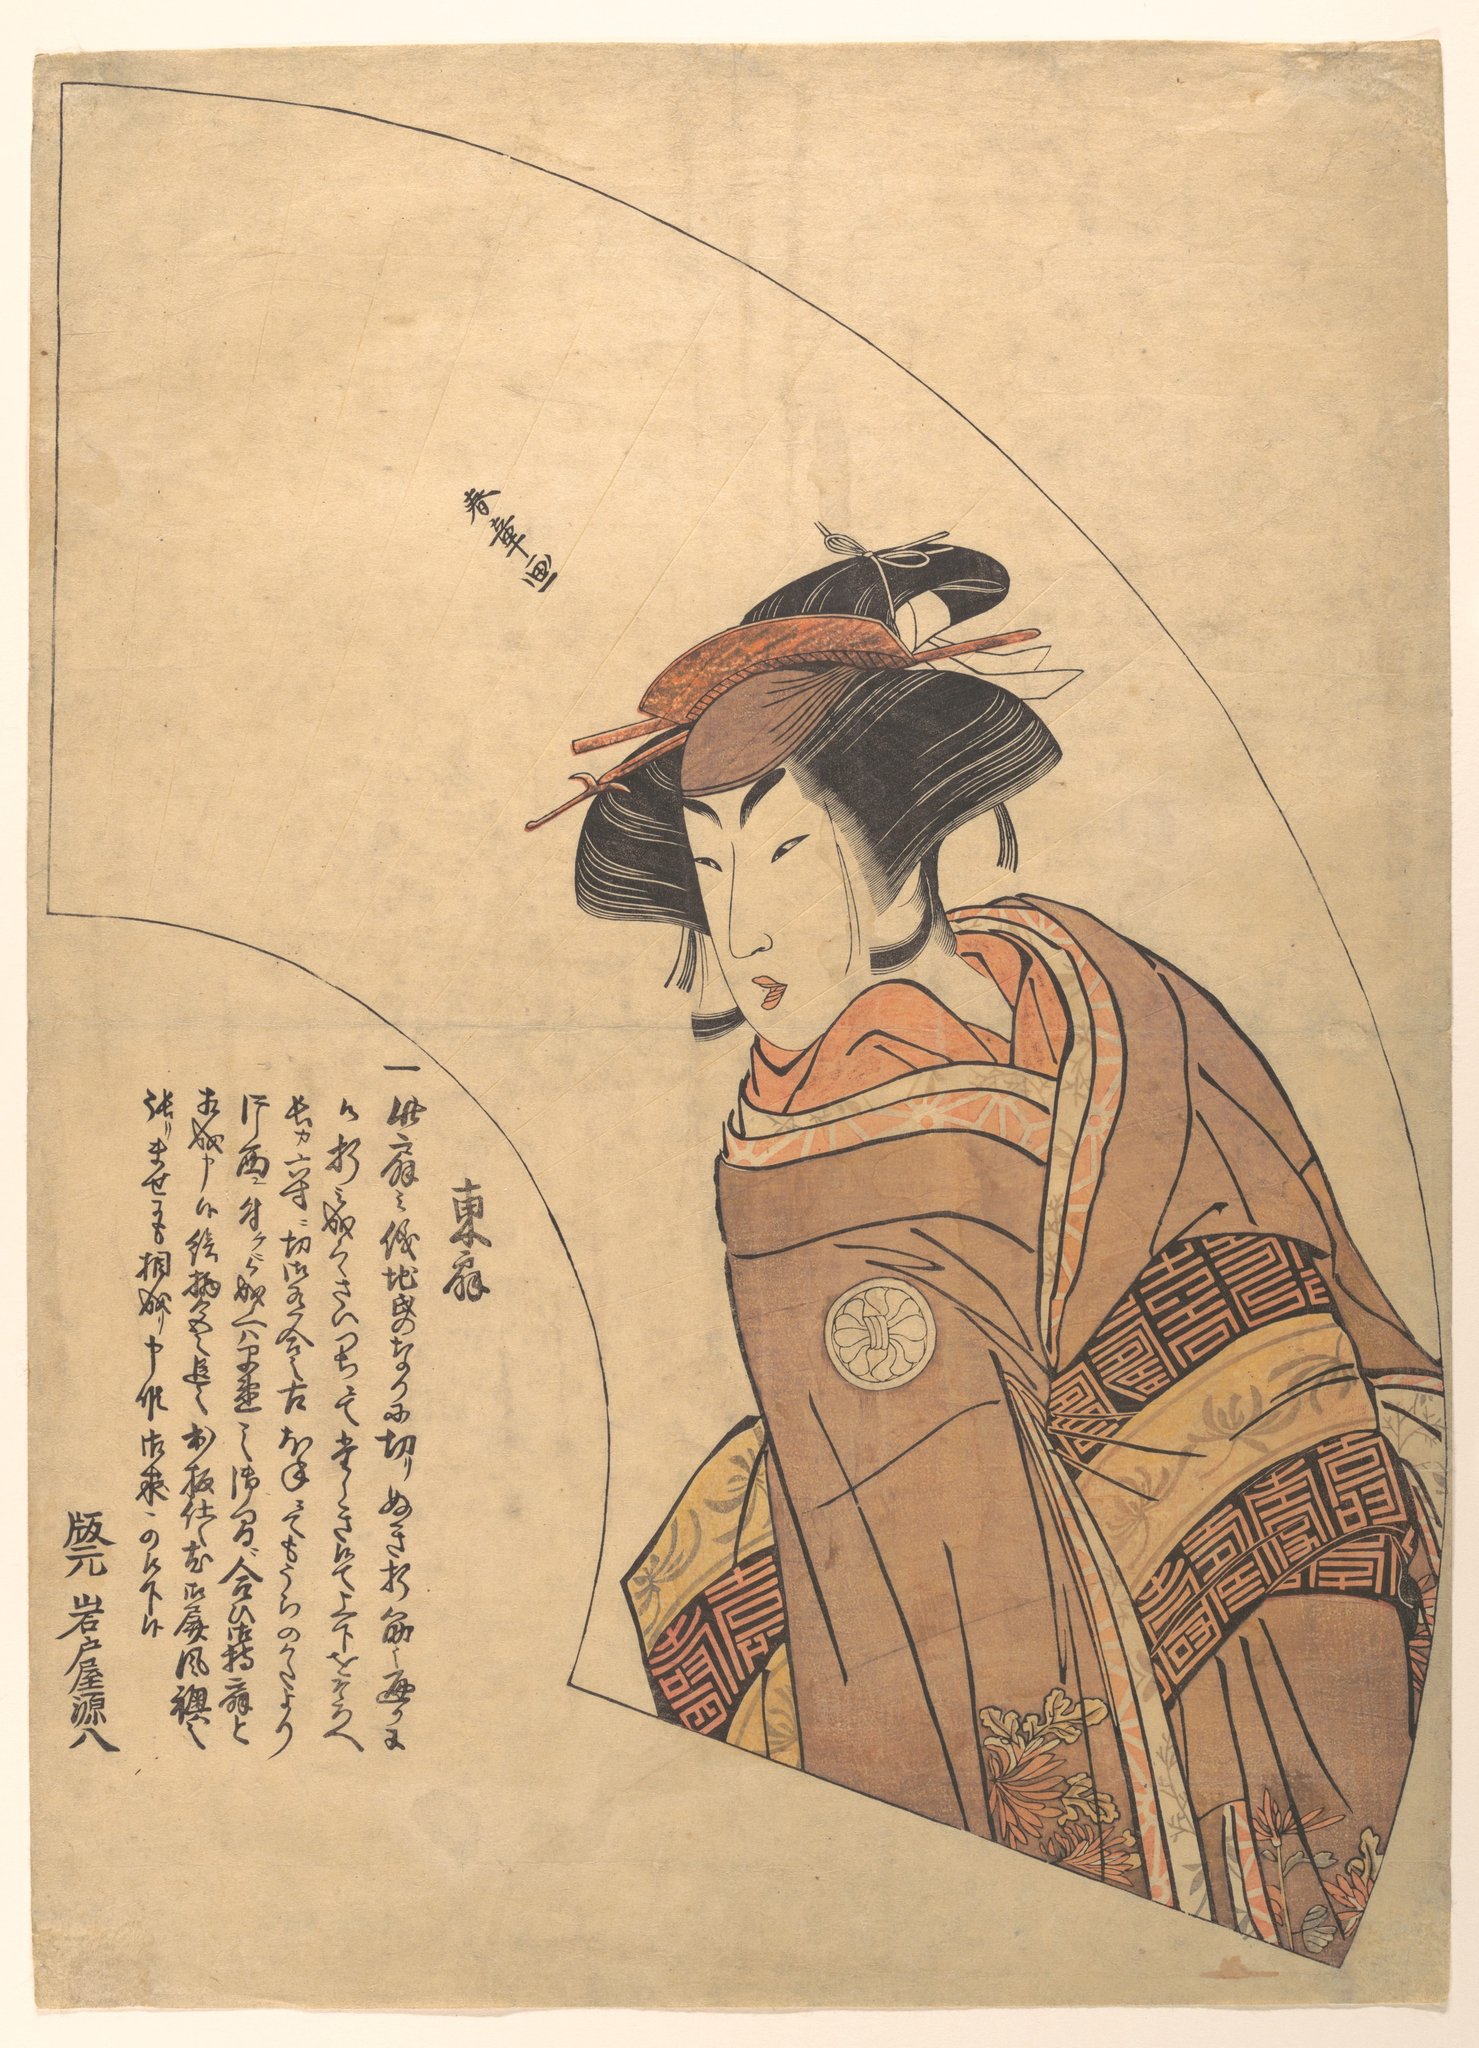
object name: woodblock print nishiki e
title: Fan Print of the Actor Segawa Kikunojo III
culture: japanese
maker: katsukawa shunshō 勝川春章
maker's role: artist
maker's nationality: japanese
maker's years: 1726-1792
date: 1775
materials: ink, paper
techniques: nishiki e, woodblock print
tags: men,women,actors